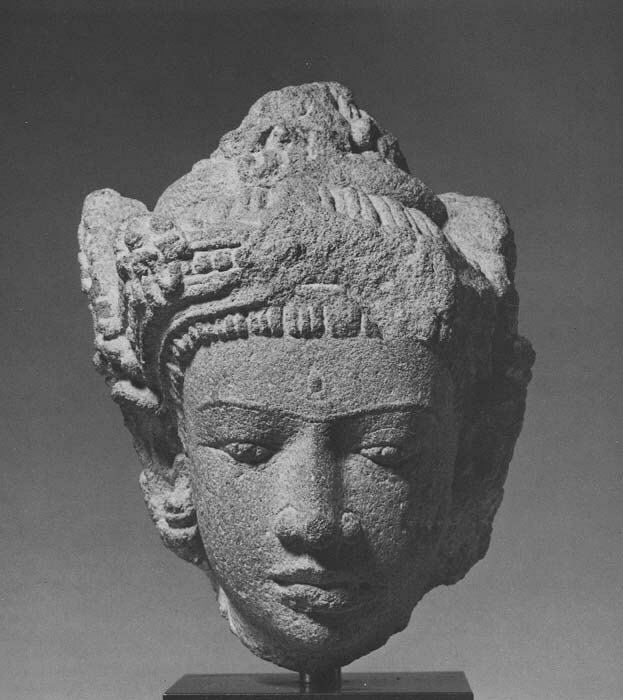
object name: head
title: Head of a Male Deity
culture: indonesian, javanese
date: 851-900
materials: stone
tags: heads